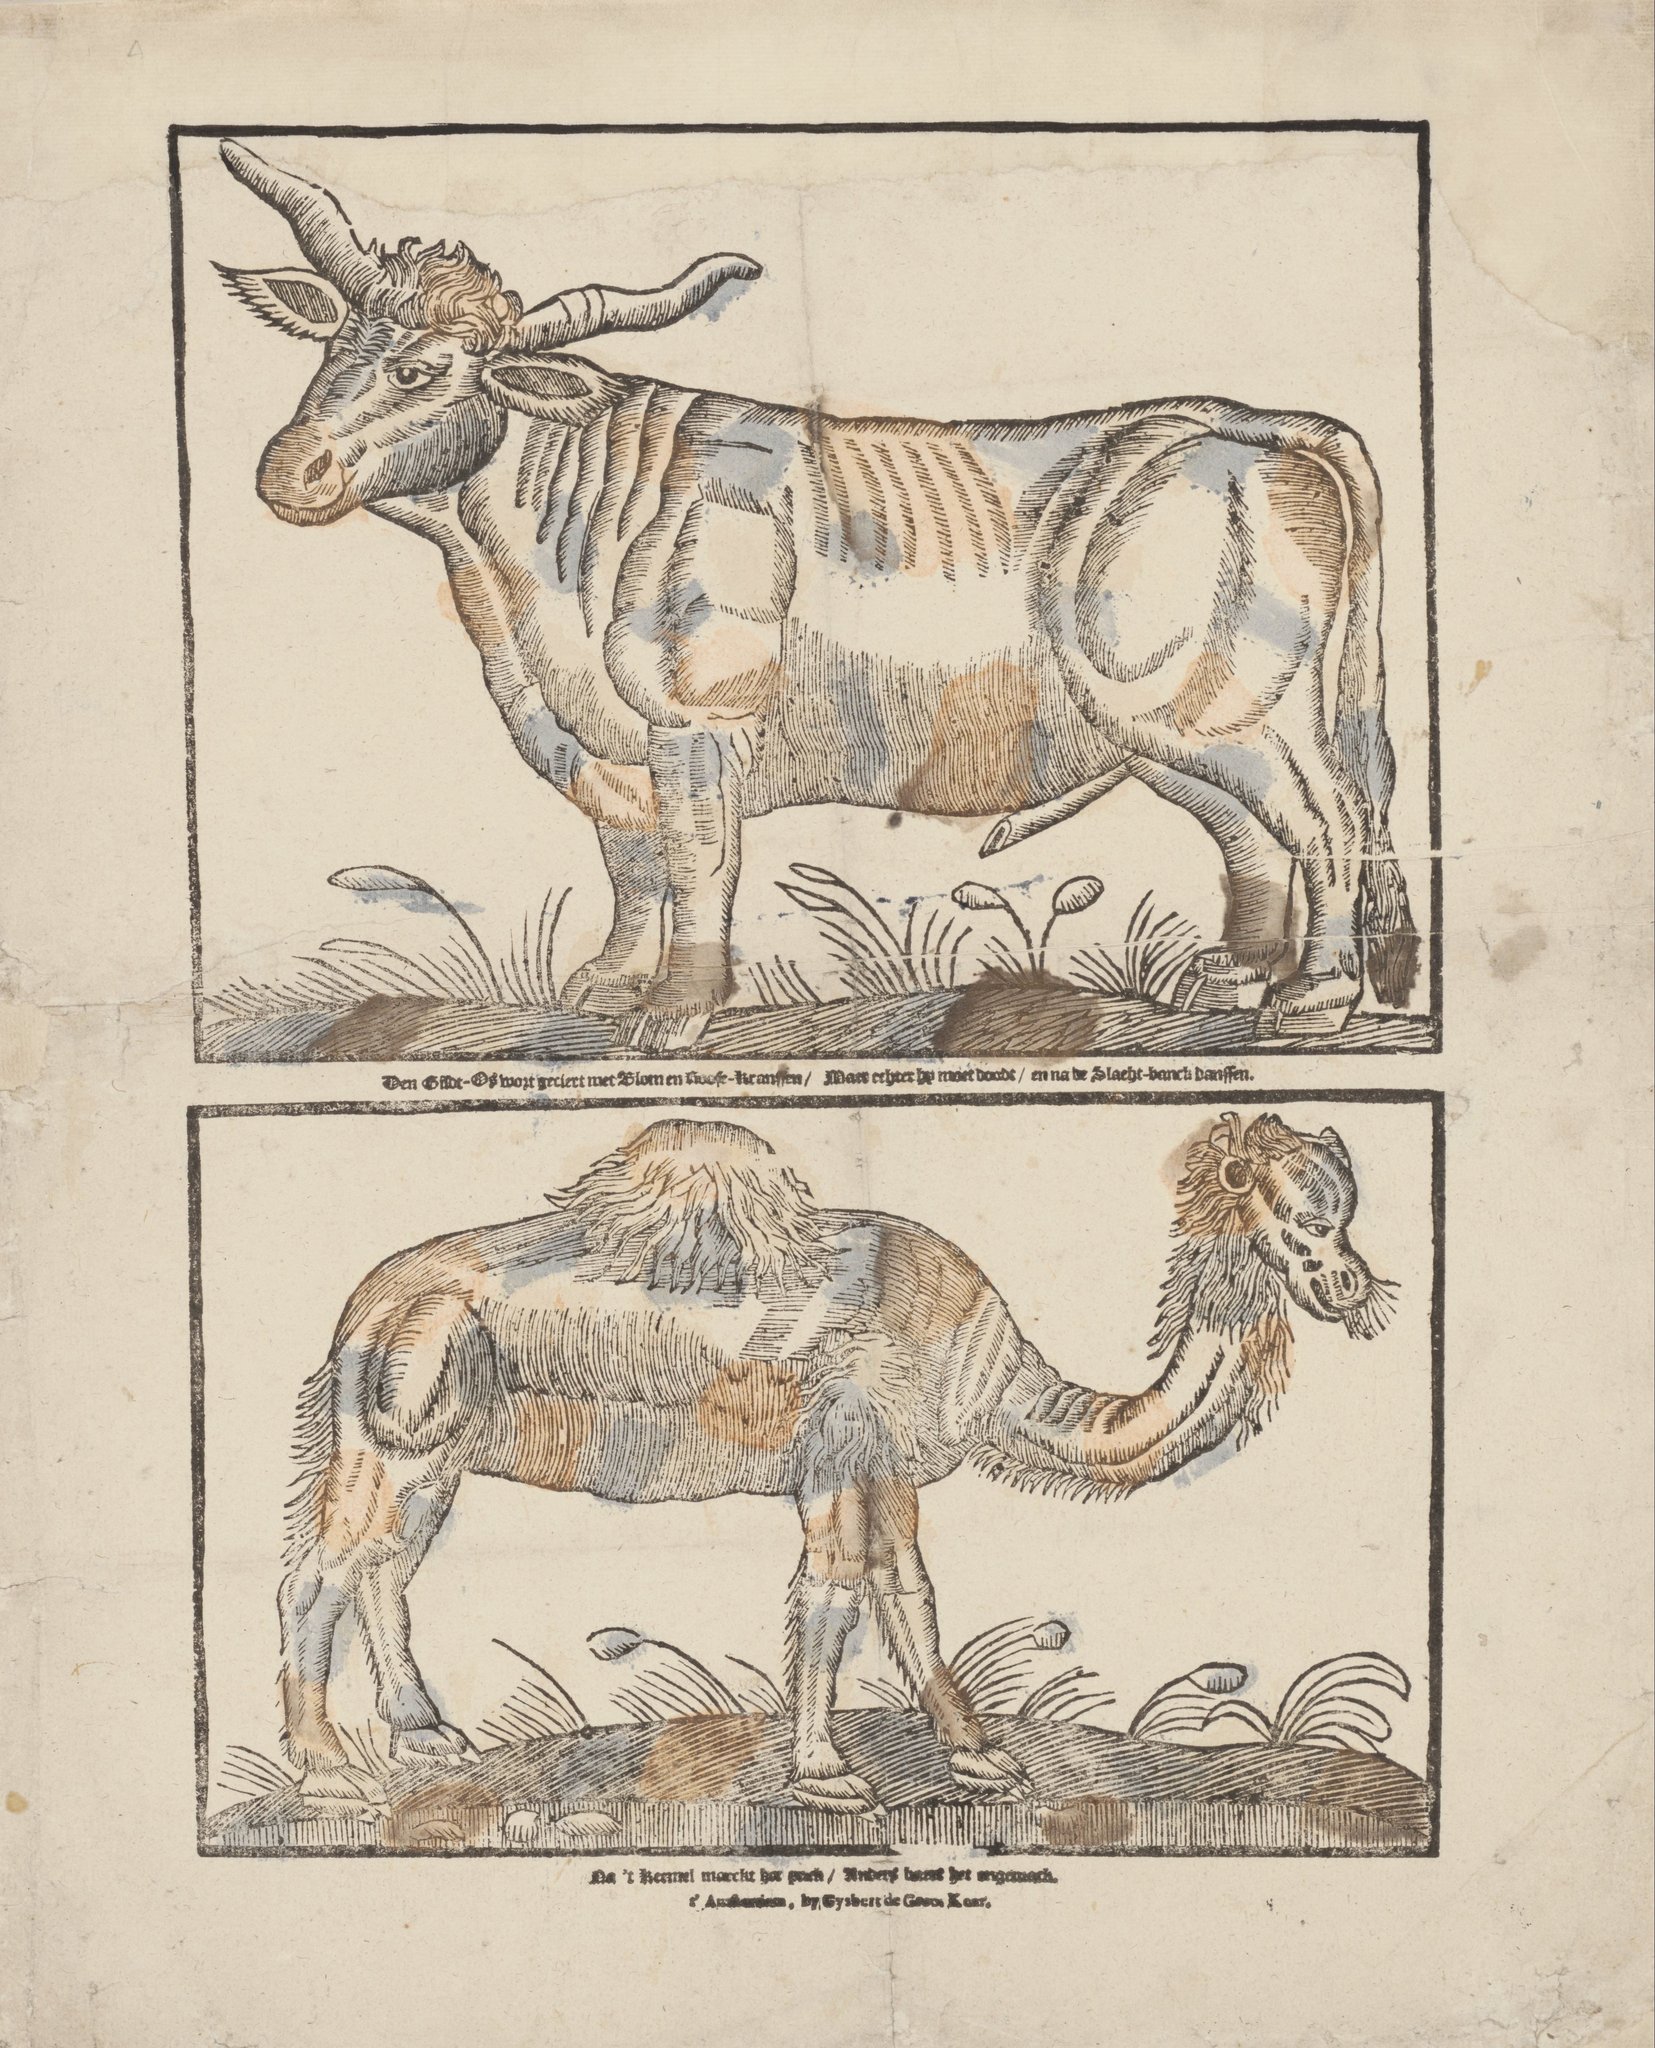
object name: print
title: Os en kameel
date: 1738-1767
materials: paper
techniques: colour, letterpress printing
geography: amsterdam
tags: hoofed animals: camel, cow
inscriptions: collector's mark: Lugt 2760, collector's mark: Lugt 2228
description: Blad met 2 voorstellingen van een os (in de tekst aangeduid als een gilde-os) en een dromedaris (in de tekst aangeduid als een kameel). Onder elke afbeelding een onderschrift.